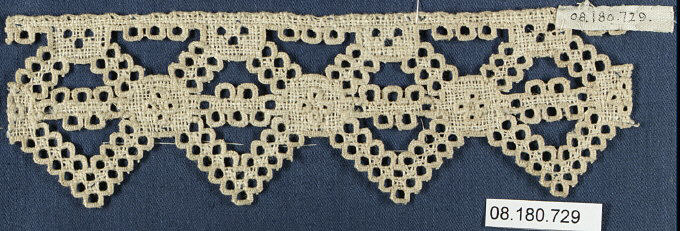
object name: fragment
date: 1801-1900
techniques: embroidery